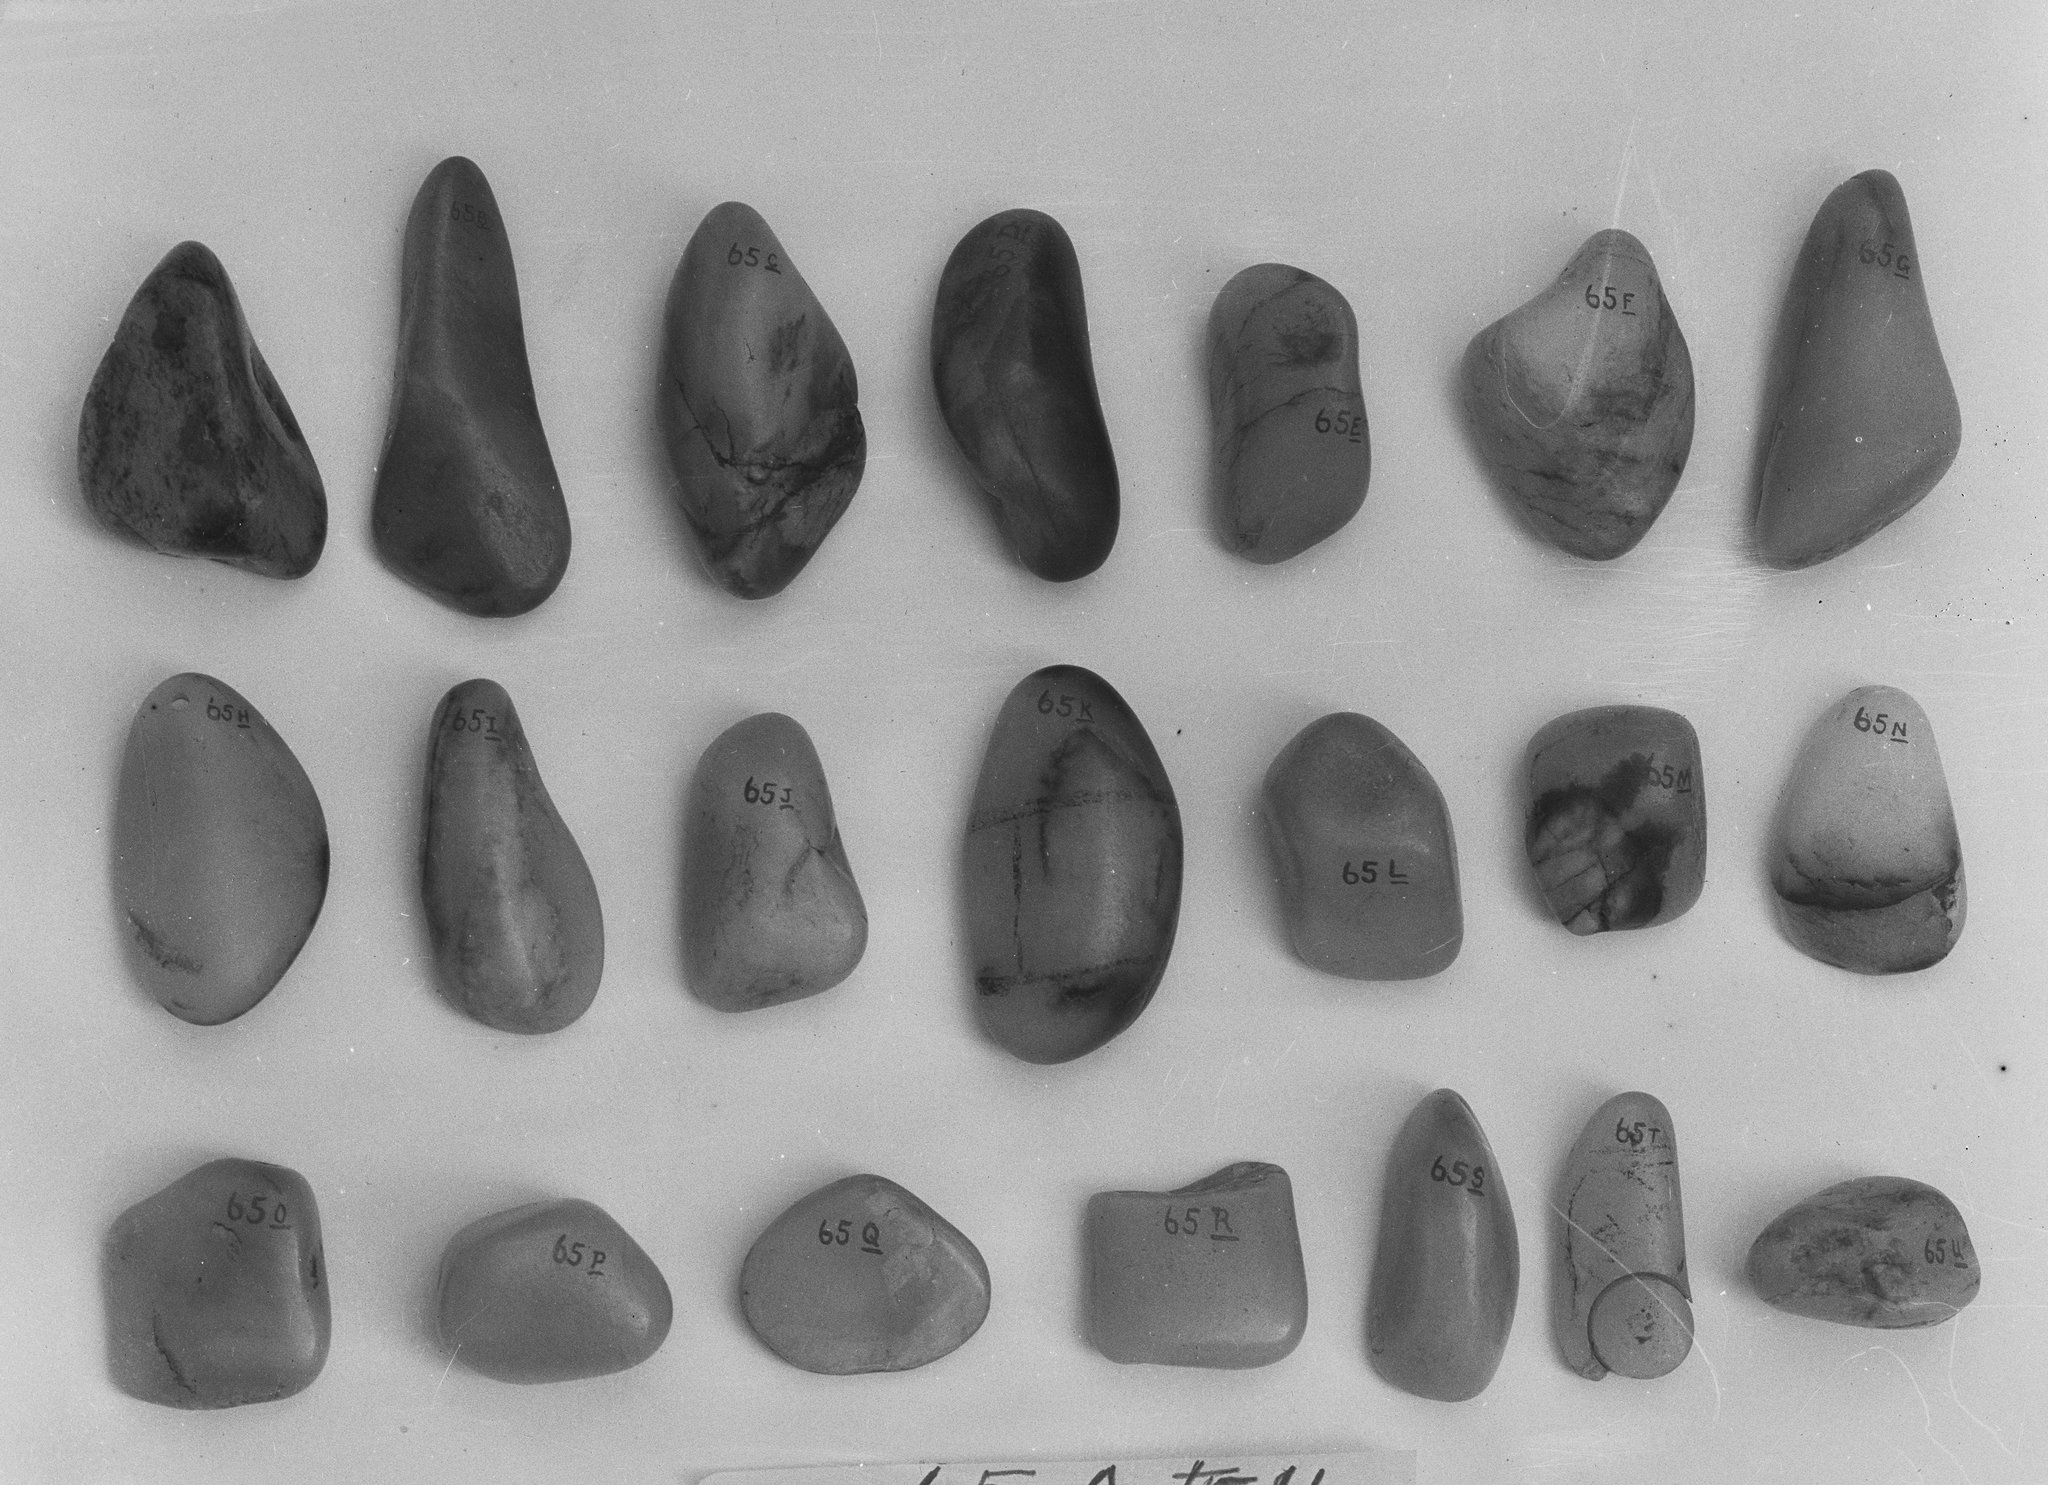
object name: pebble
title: Twenty-One Pebbles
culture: chinese or turkestani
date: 1902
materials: jade